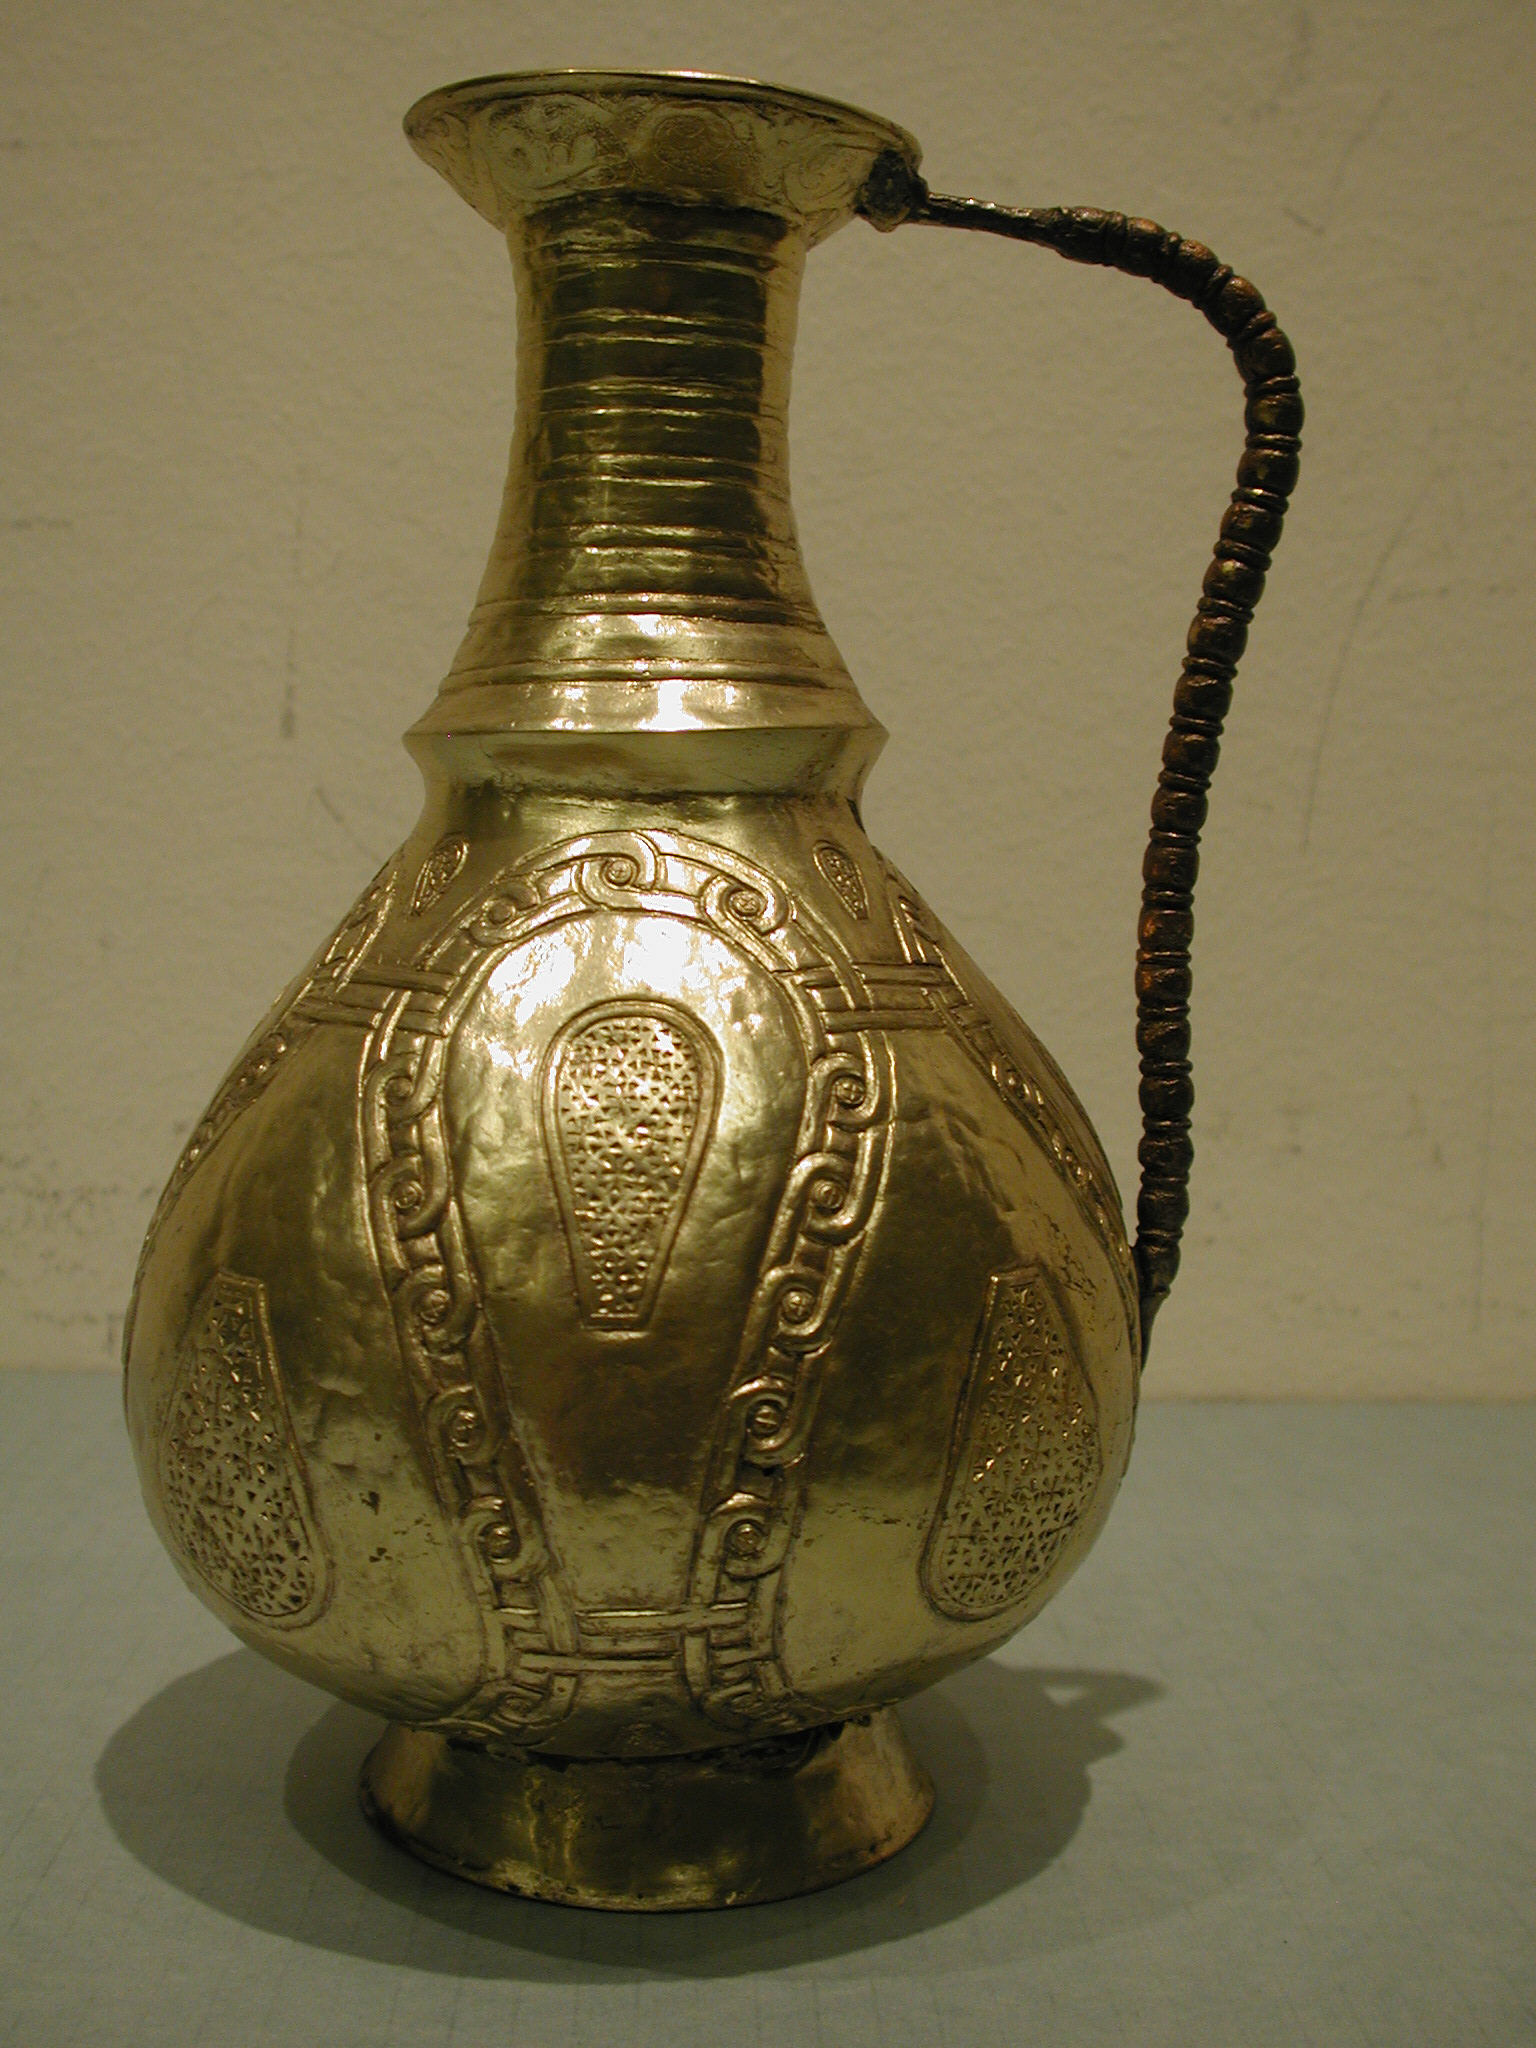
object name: ewer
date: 1801-1900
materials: metal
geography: hungary